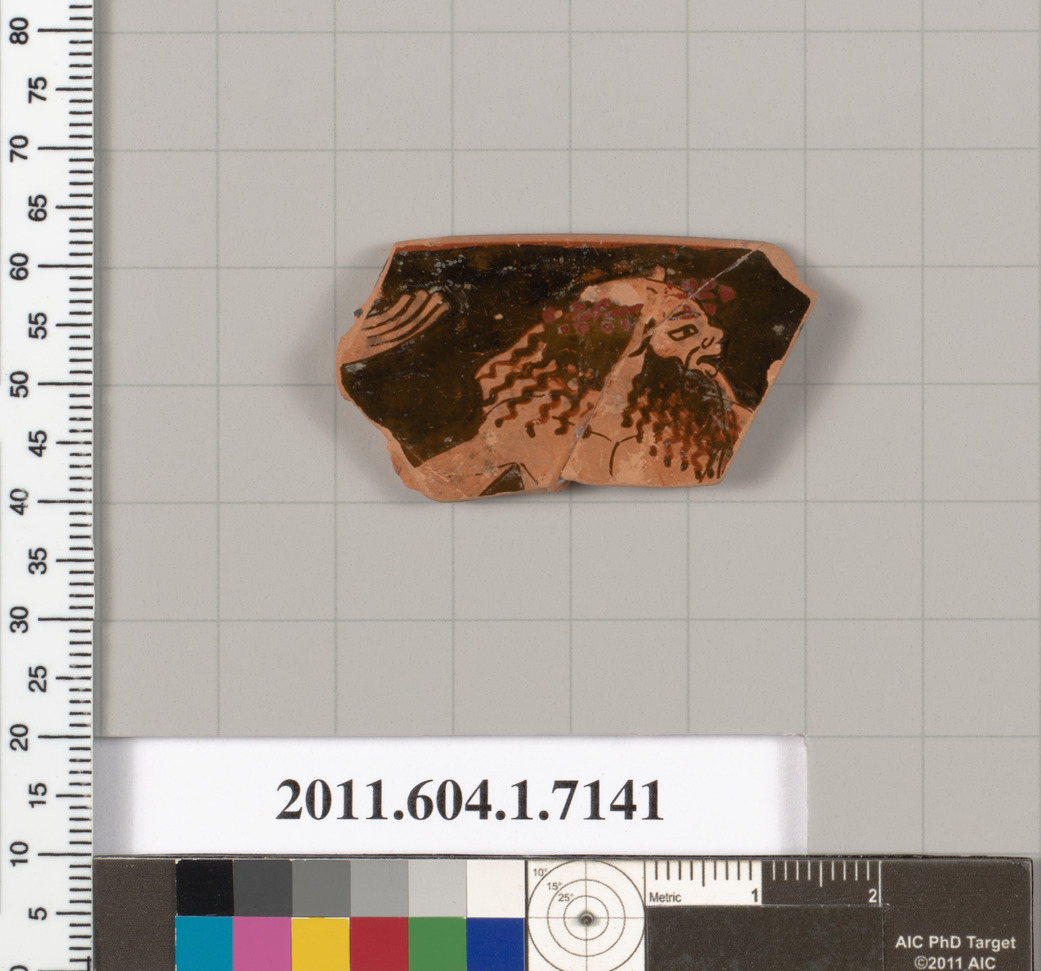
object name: kylix fragment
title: Terracotta rim fragment of a kylix (drinking cup)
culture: greek, attic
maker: makron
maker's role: artist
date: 500-480 BCE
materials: terracotta